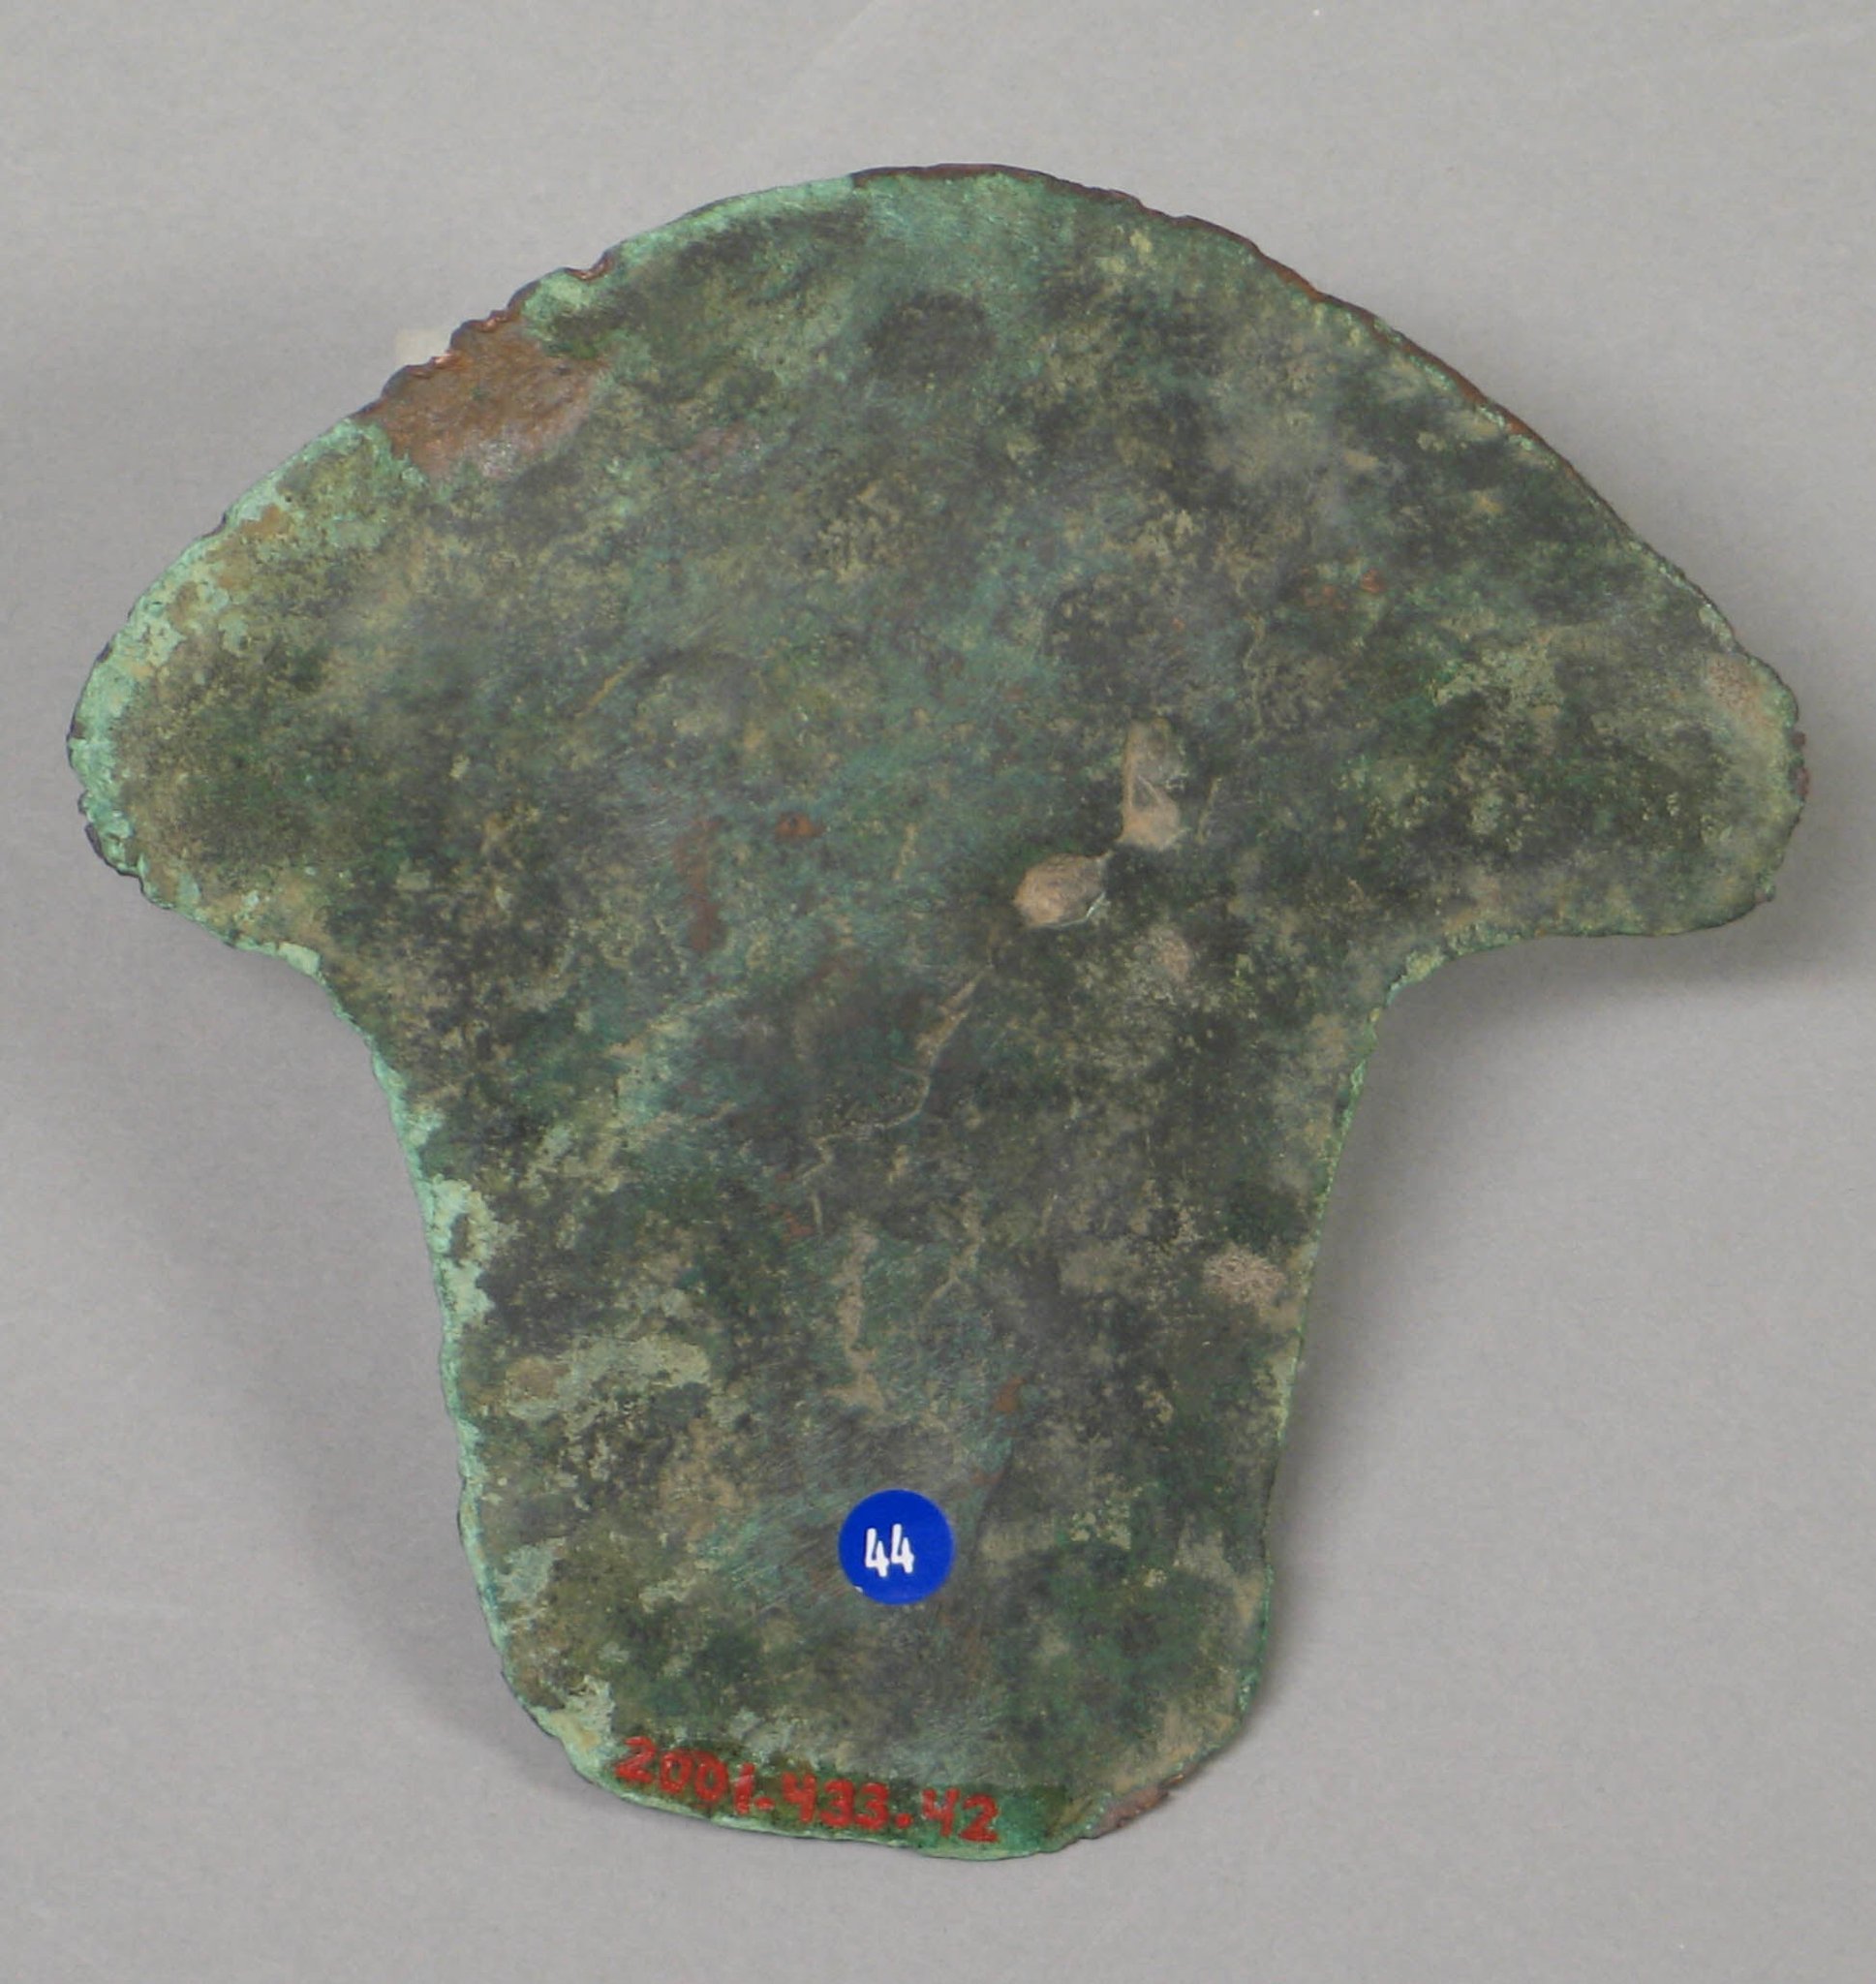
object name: ax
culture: indian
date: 1500-500 BCE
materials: copper